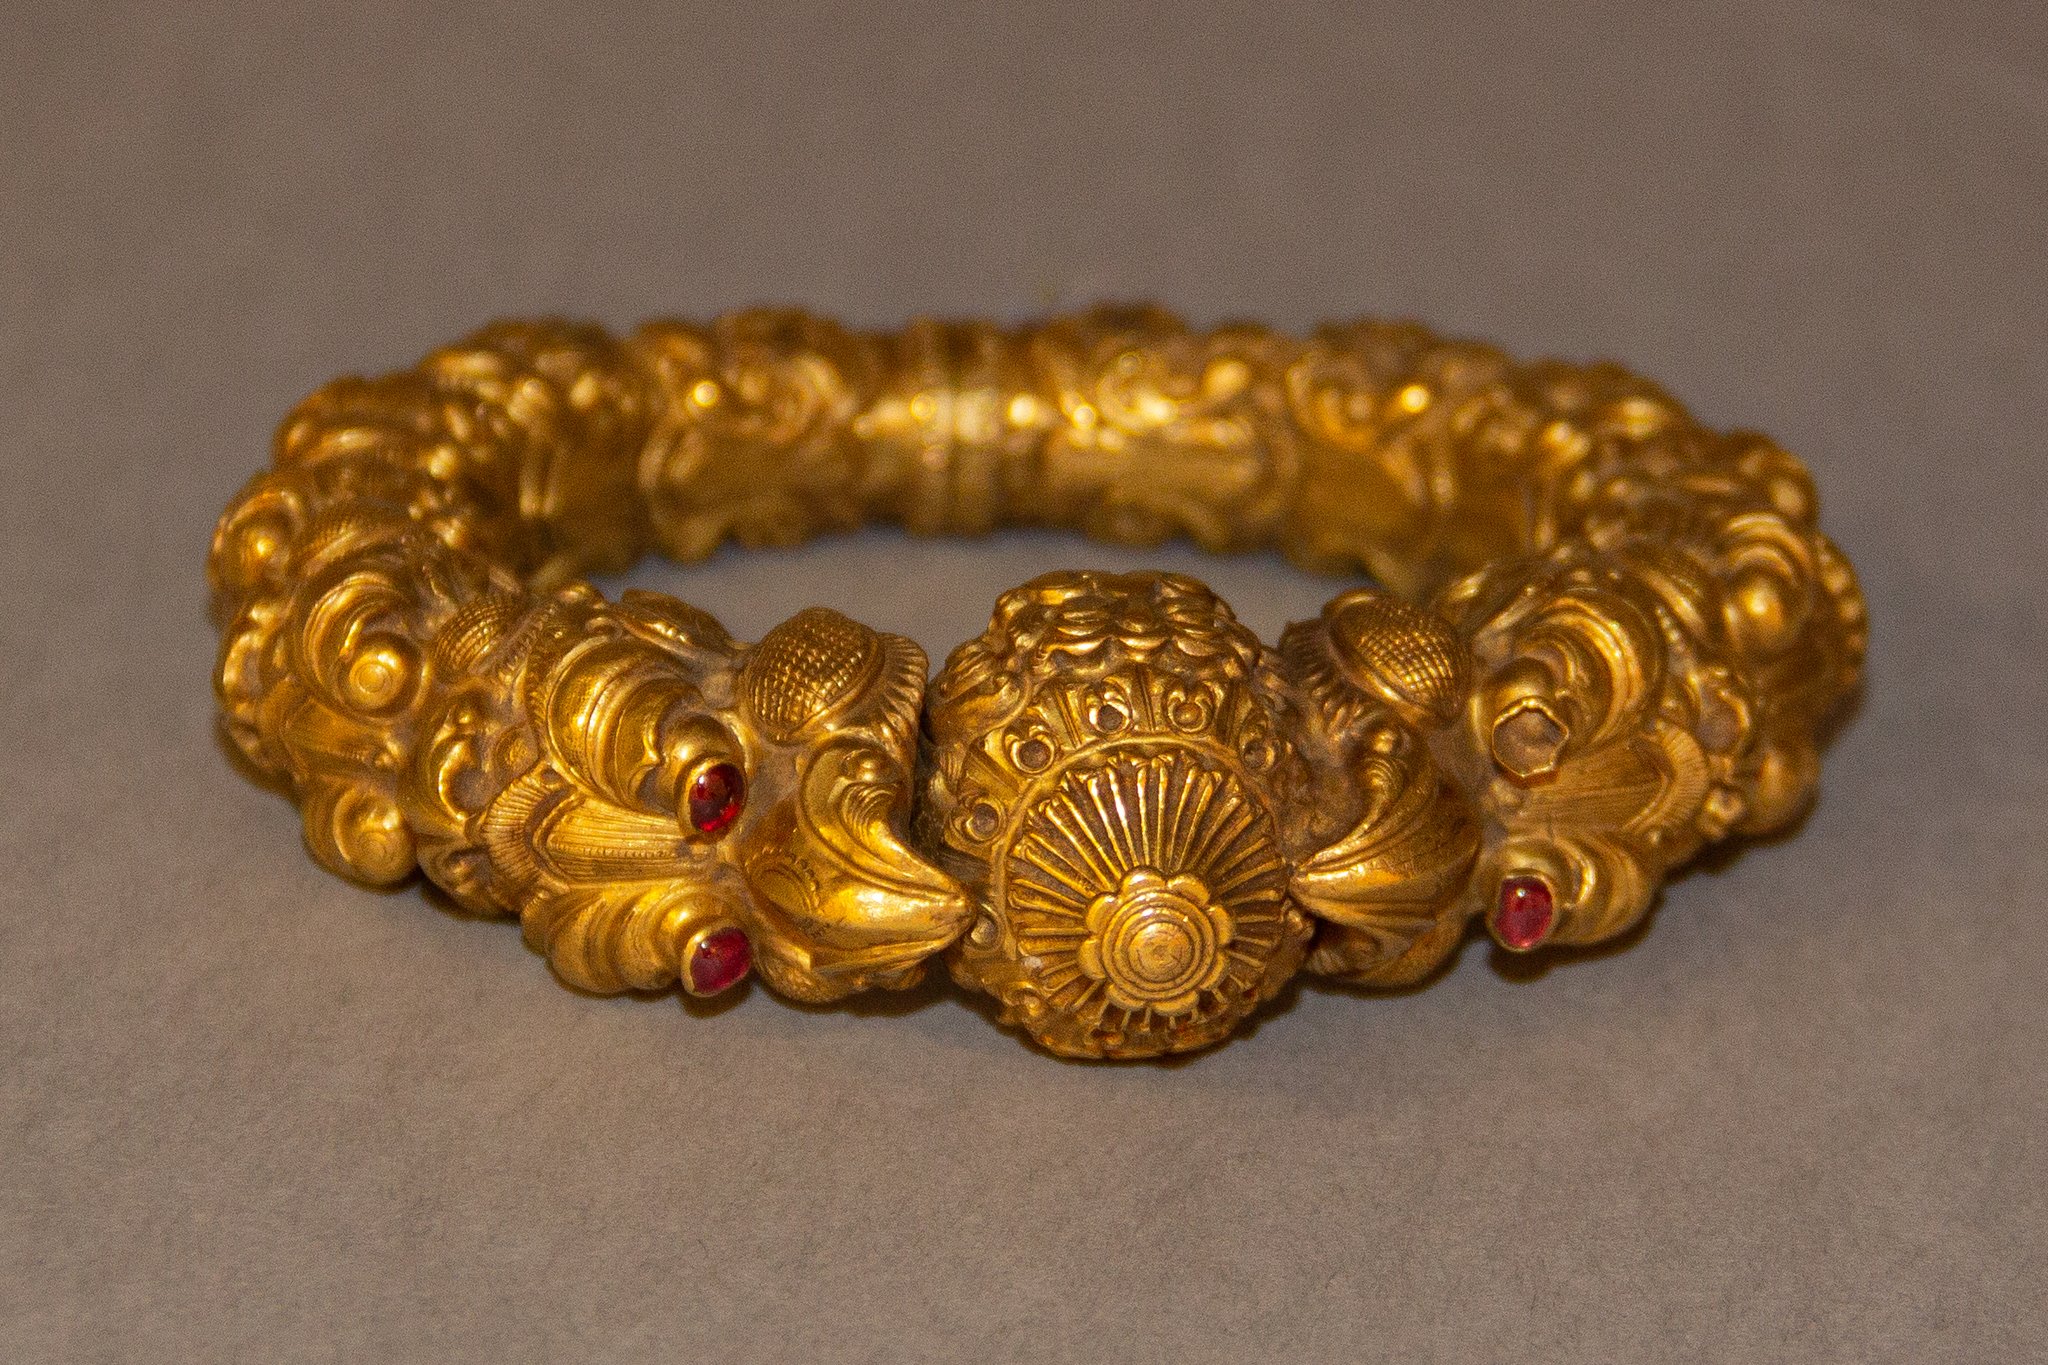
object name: bracelet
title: Bracelet (Kada), One of a Pair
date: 1801-1900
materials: gold, gemstone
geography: india